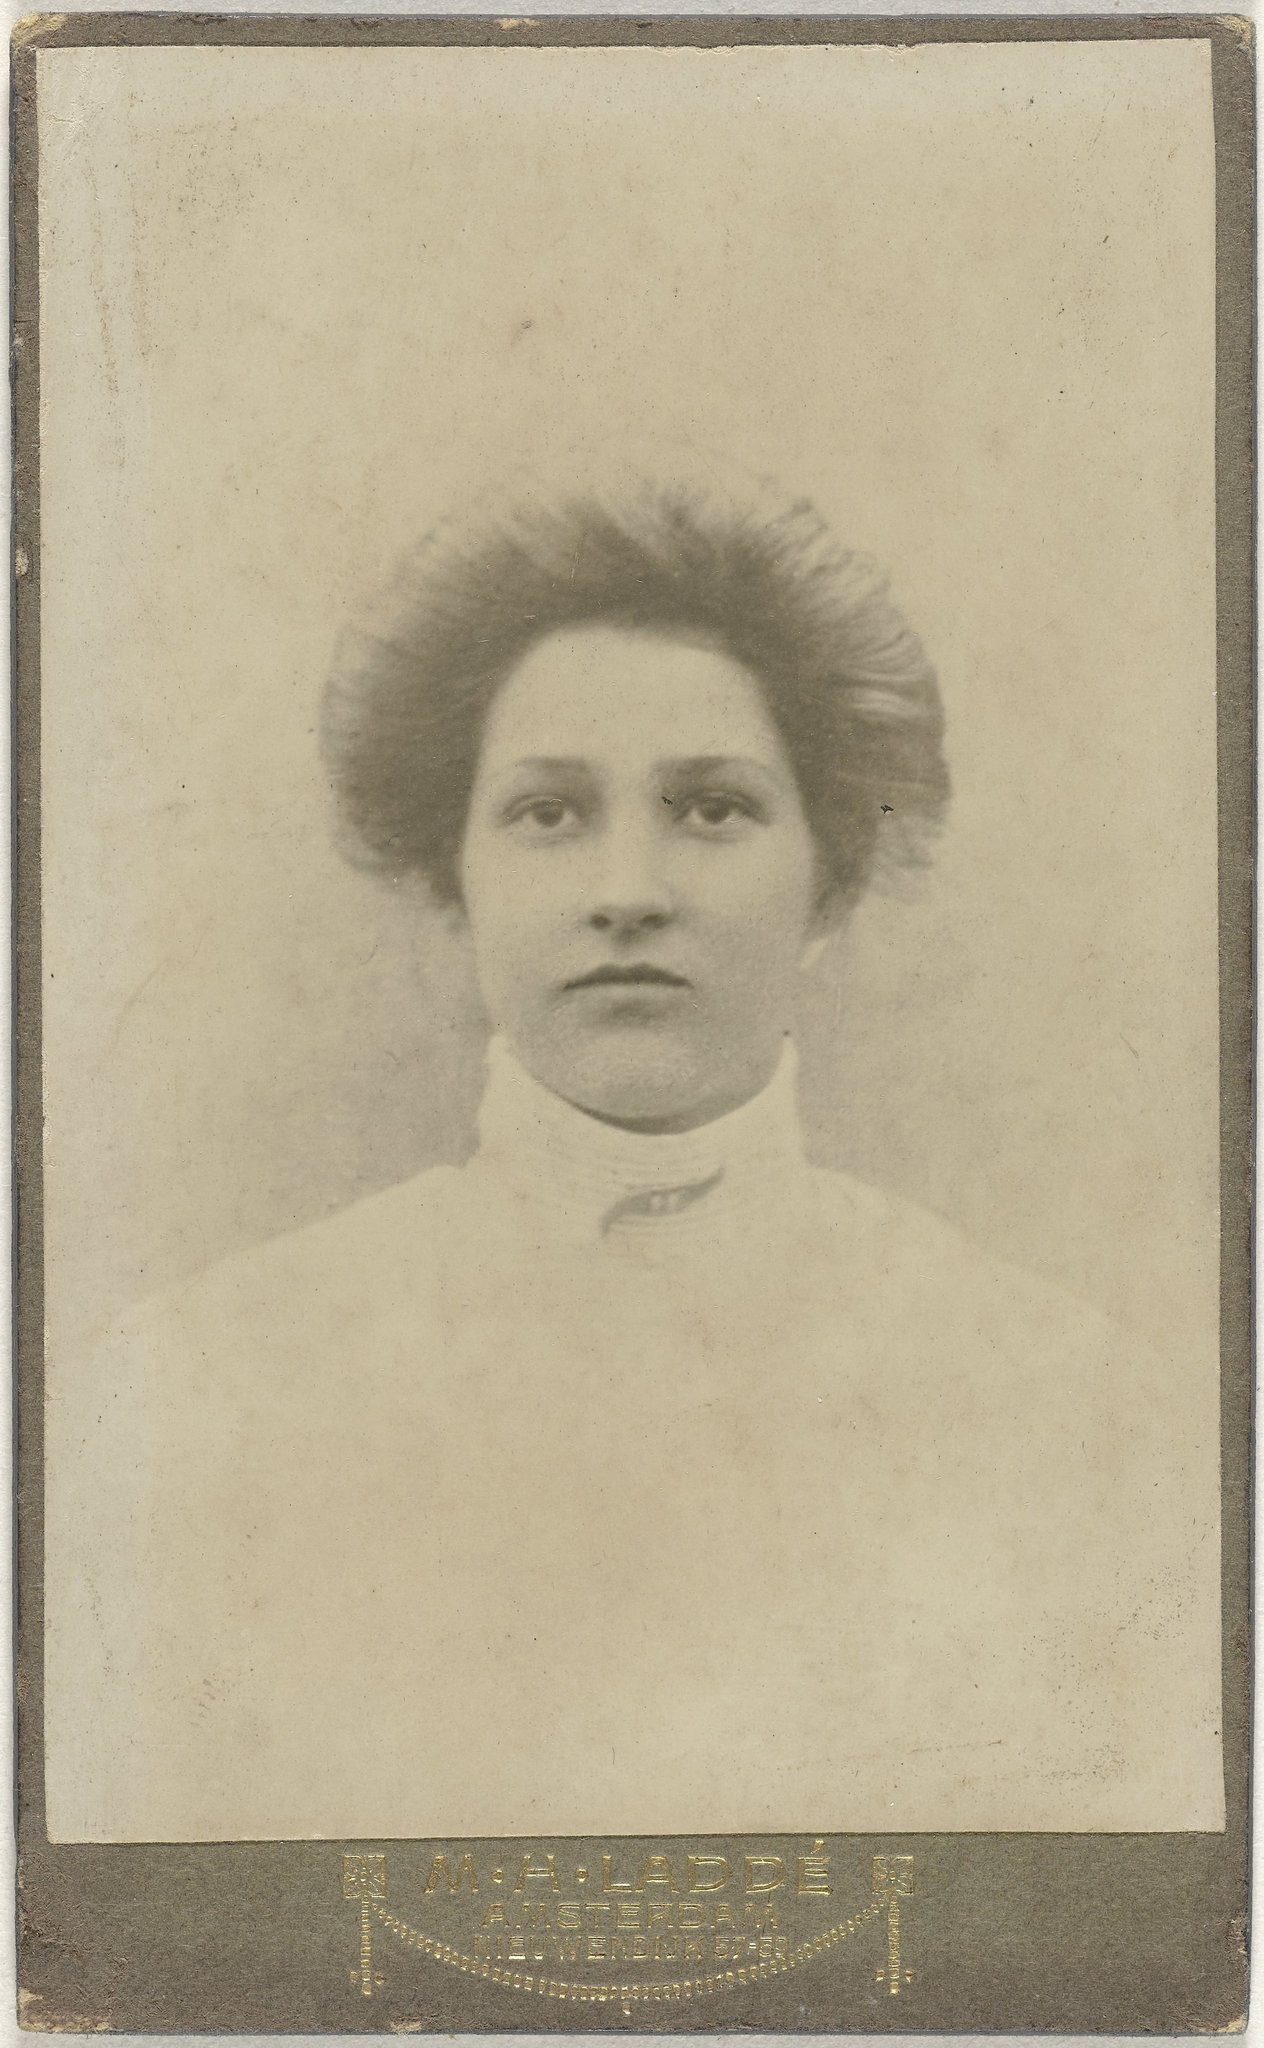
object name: carte de visite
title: Studioportret van vrouw, buste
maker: machiel hendricus laddé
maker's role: fotograaf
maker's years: 1866-1932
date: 1880-1920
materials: photographic support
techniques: collodion silver print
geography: amsterdam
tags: chest, bust - aa - female human figure, utrecht